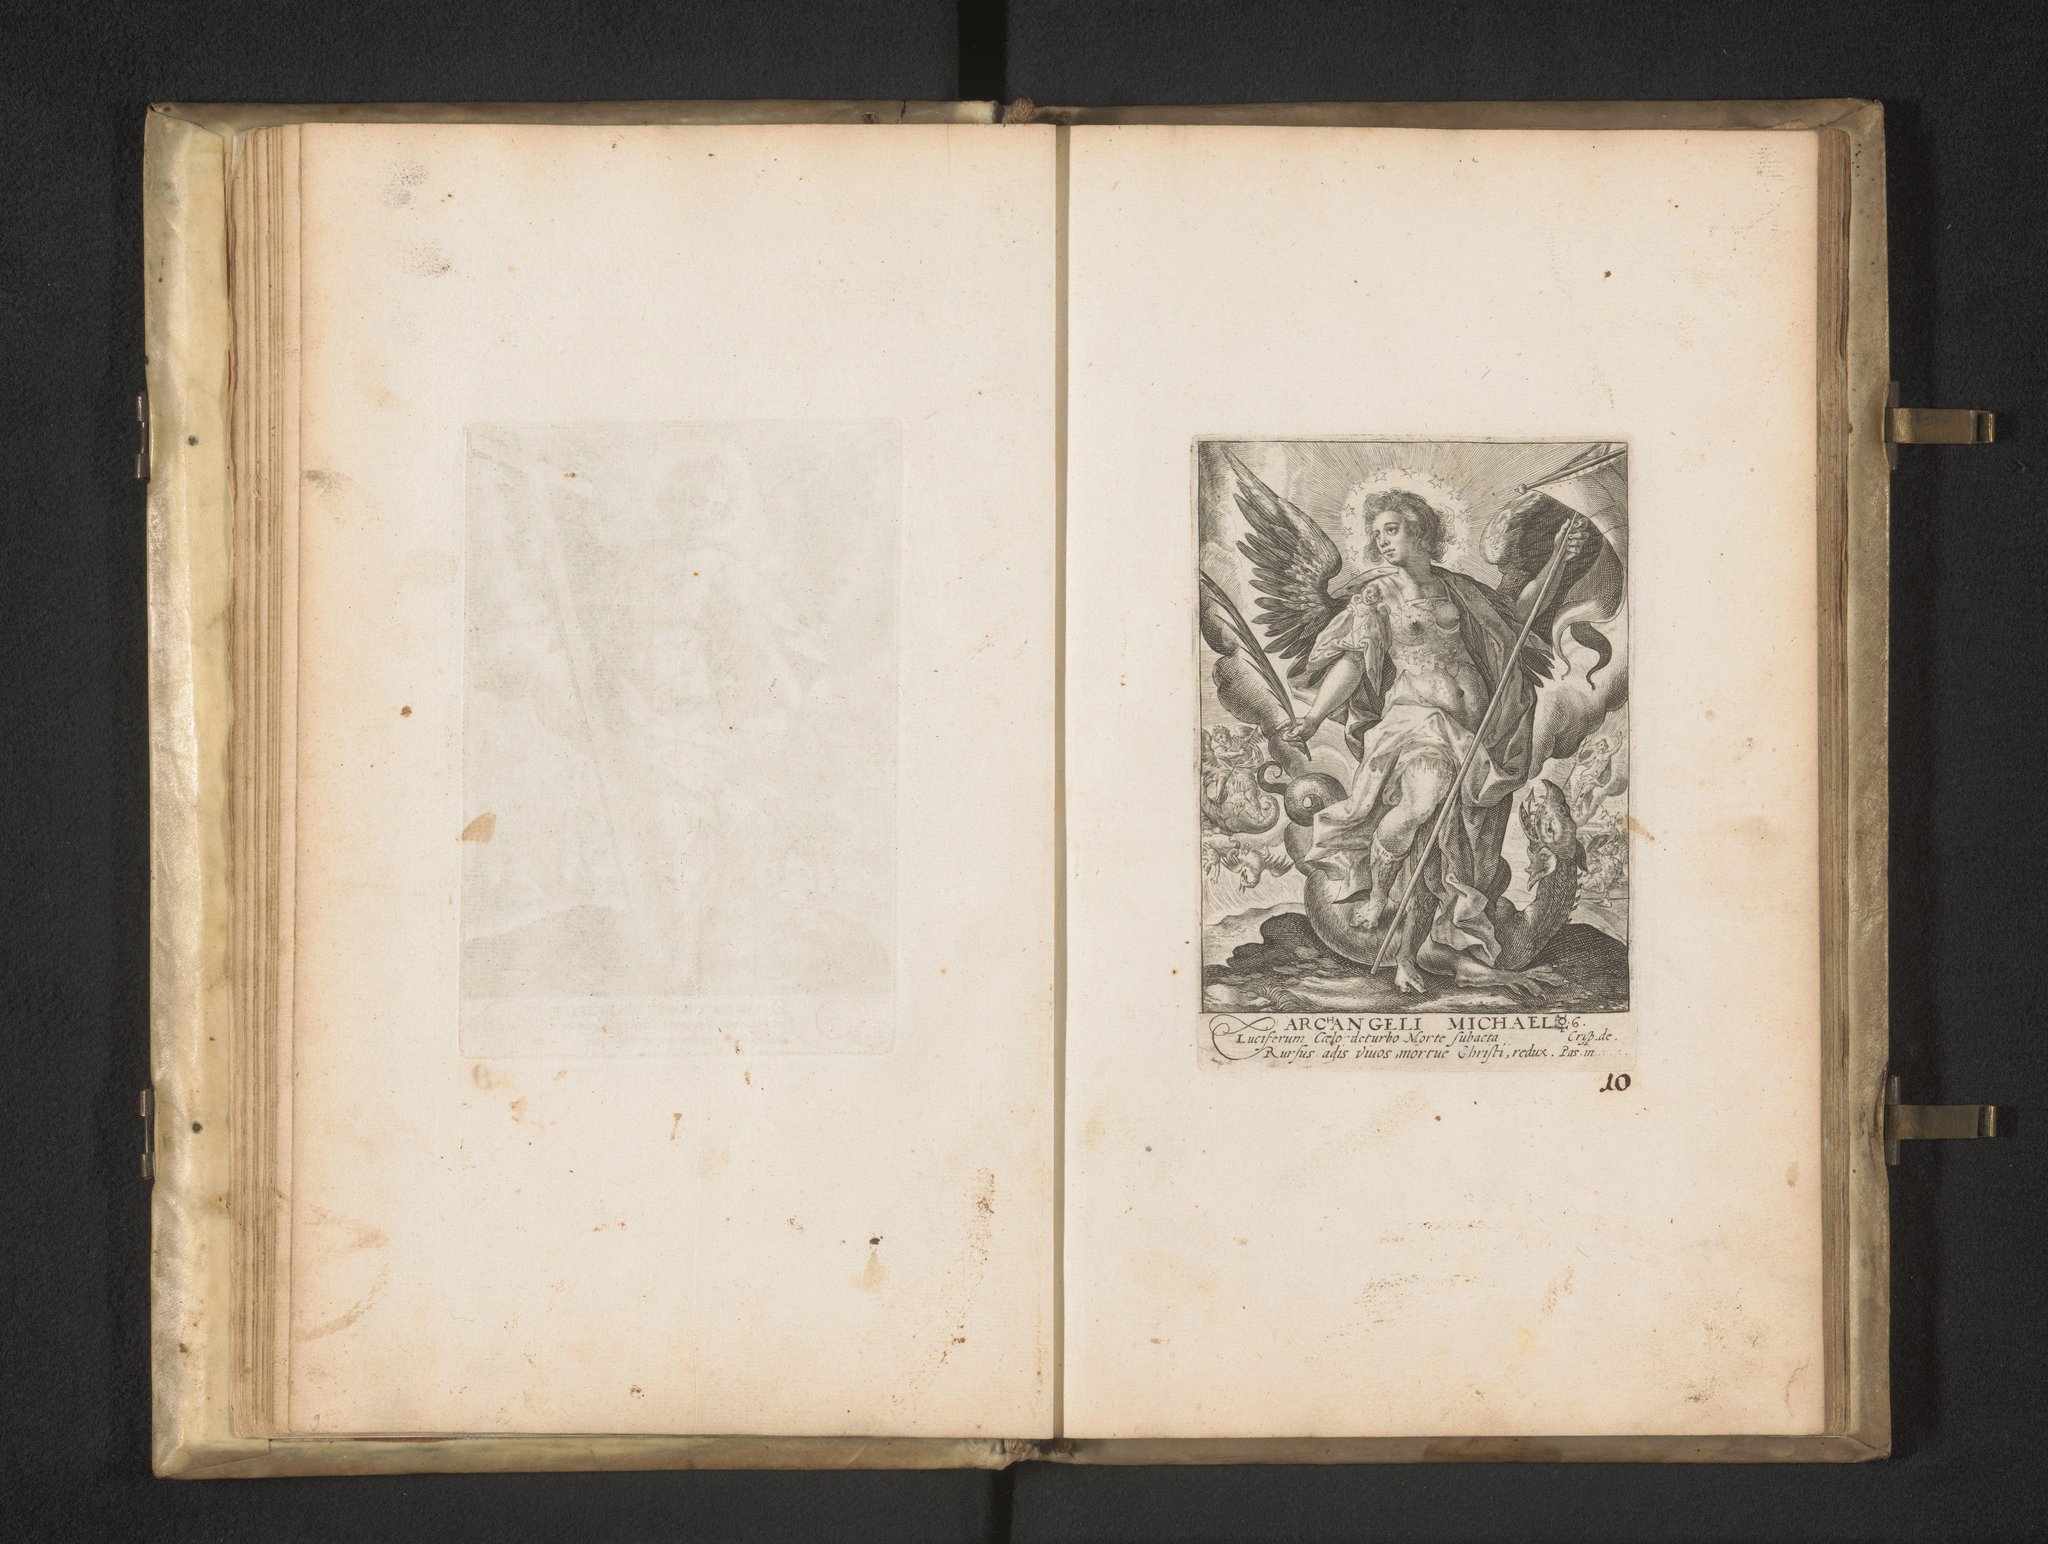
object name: print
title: Aartsengelen en andere engelen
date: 1585-1637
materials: paper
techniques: engraving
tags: the archangel michael (often in armour with sword or lance), last judgement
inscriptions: number: ‘10’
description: Aartsengel Michaël met palmtak en vaandel. Op de achtergrond scènes van het Laatste Oordeel. Genummerd in het inderschrift: 6. Maakt in dit album deel uit van een serie van twaalf voorstellingen van aartsengelen en andere engelen. Onderdeel van een album met voornamelijk christelijke voorstellingen.